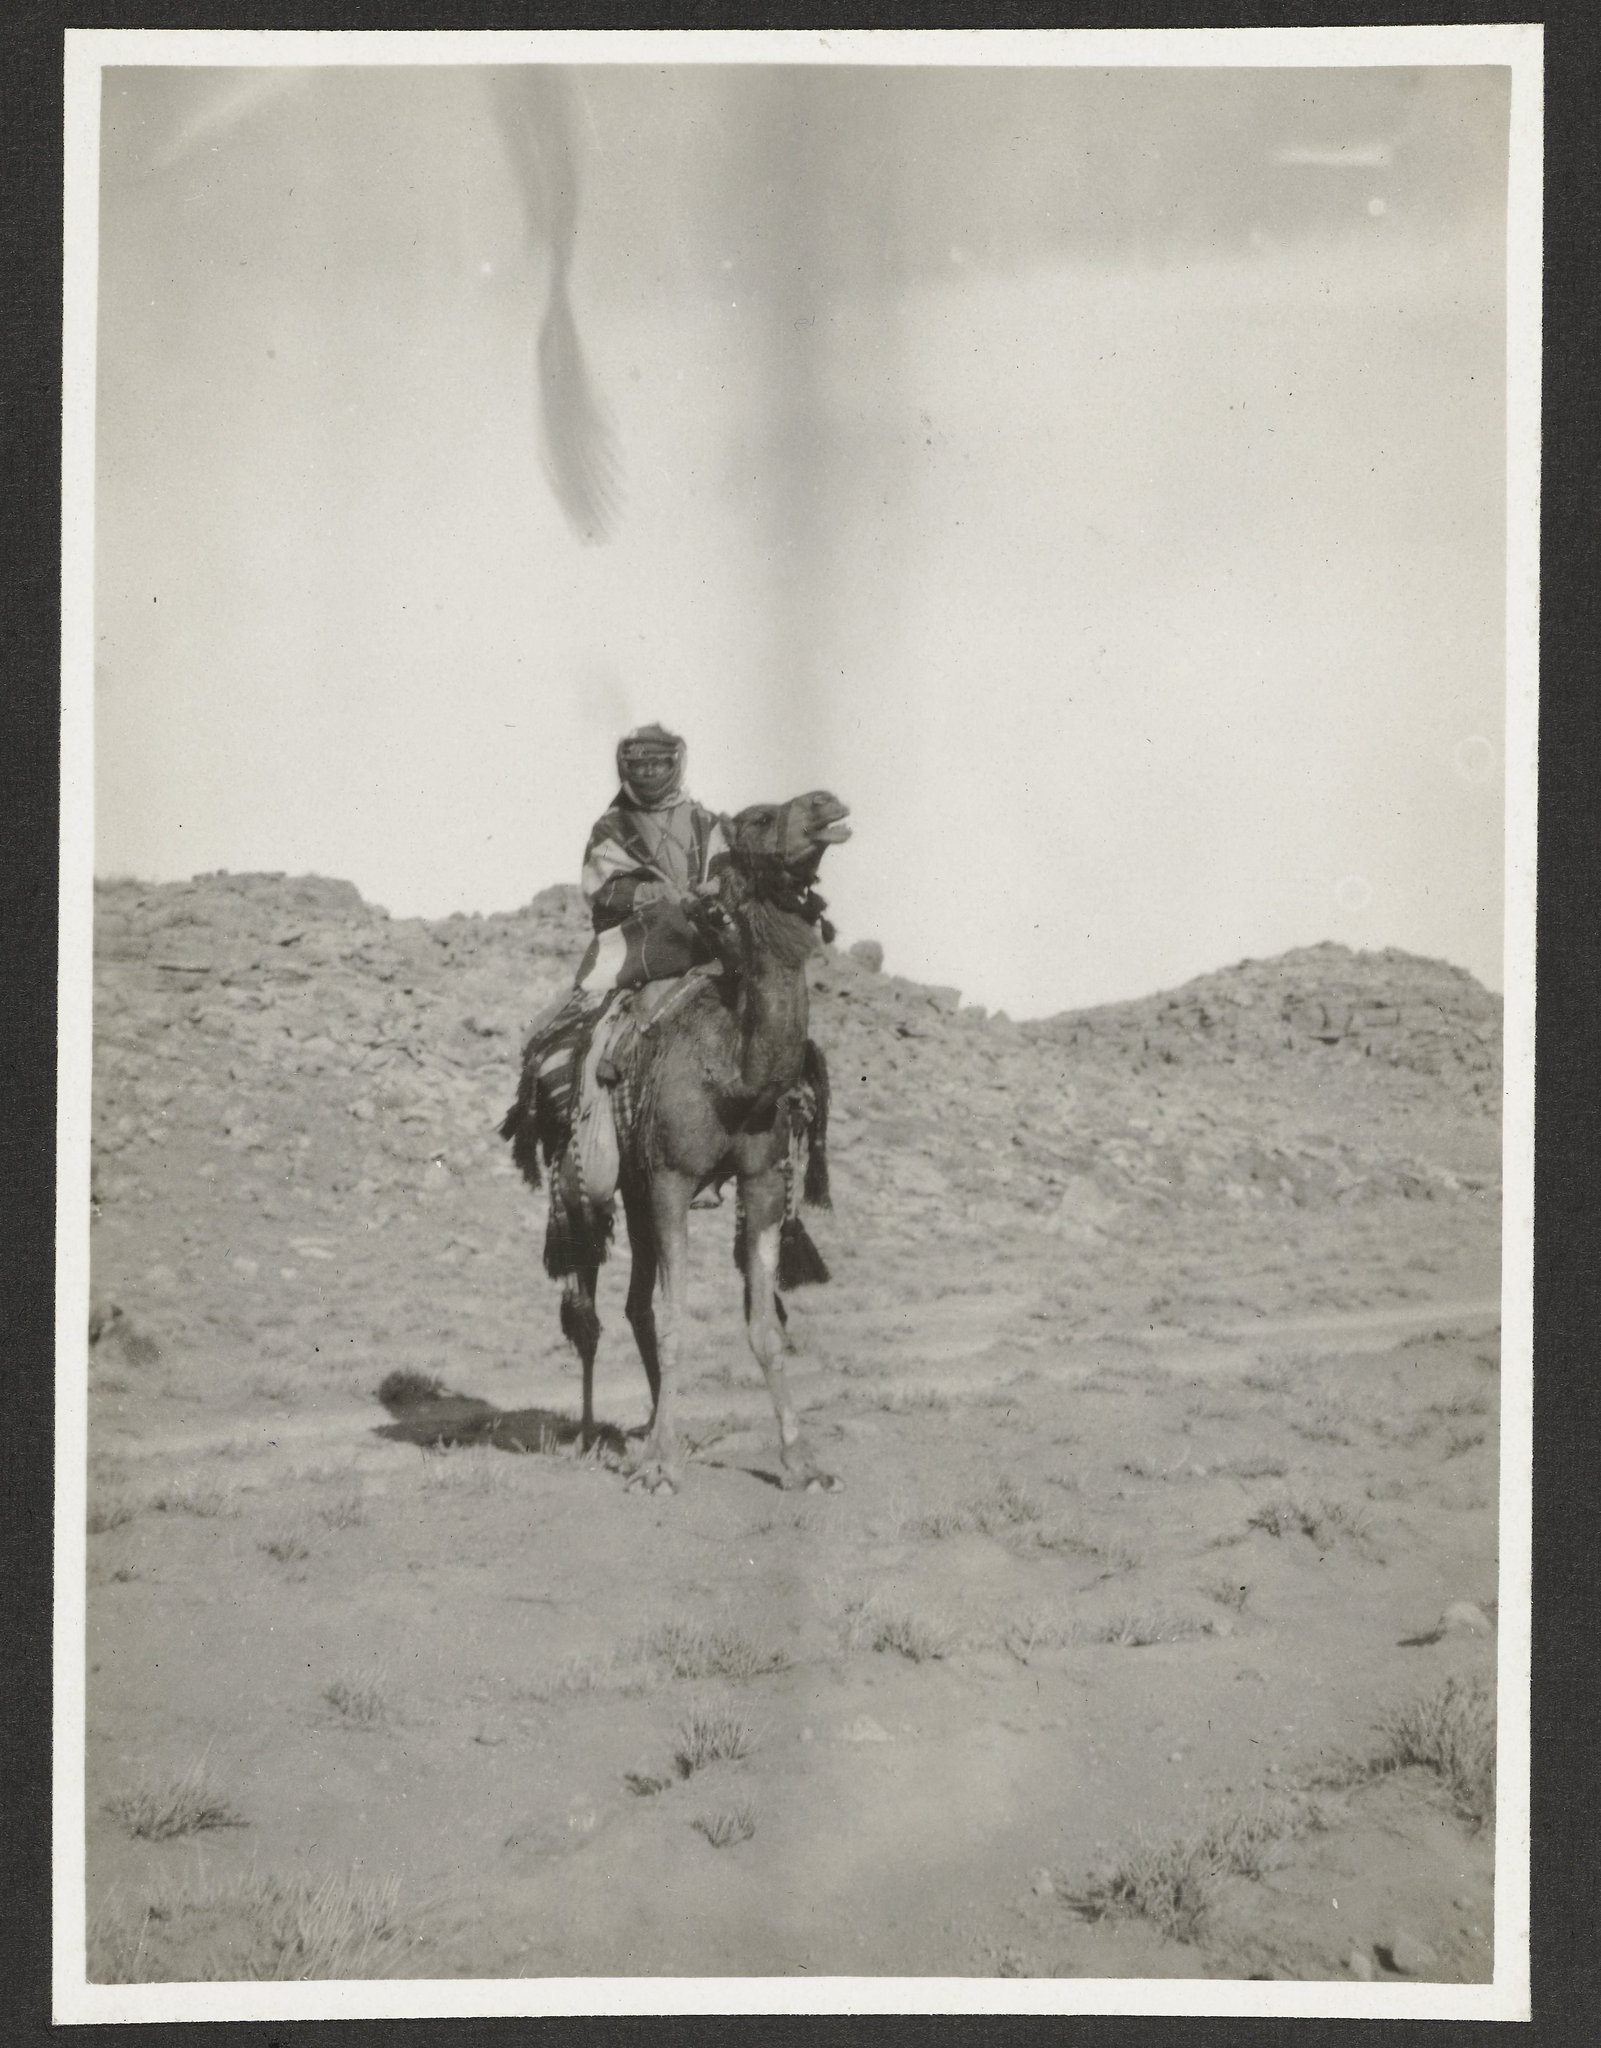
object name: photograph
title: Bereden politie.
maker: a.g.a. van eelde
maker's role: engineer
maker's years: 1862-1950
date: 1925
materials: cardboard, paper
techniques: gelatin silver print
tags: syrië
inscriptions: number: ‘6.’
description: Titel op object afkomstig uit inventaris (Verklaring der Photo's) behorend bij het album.